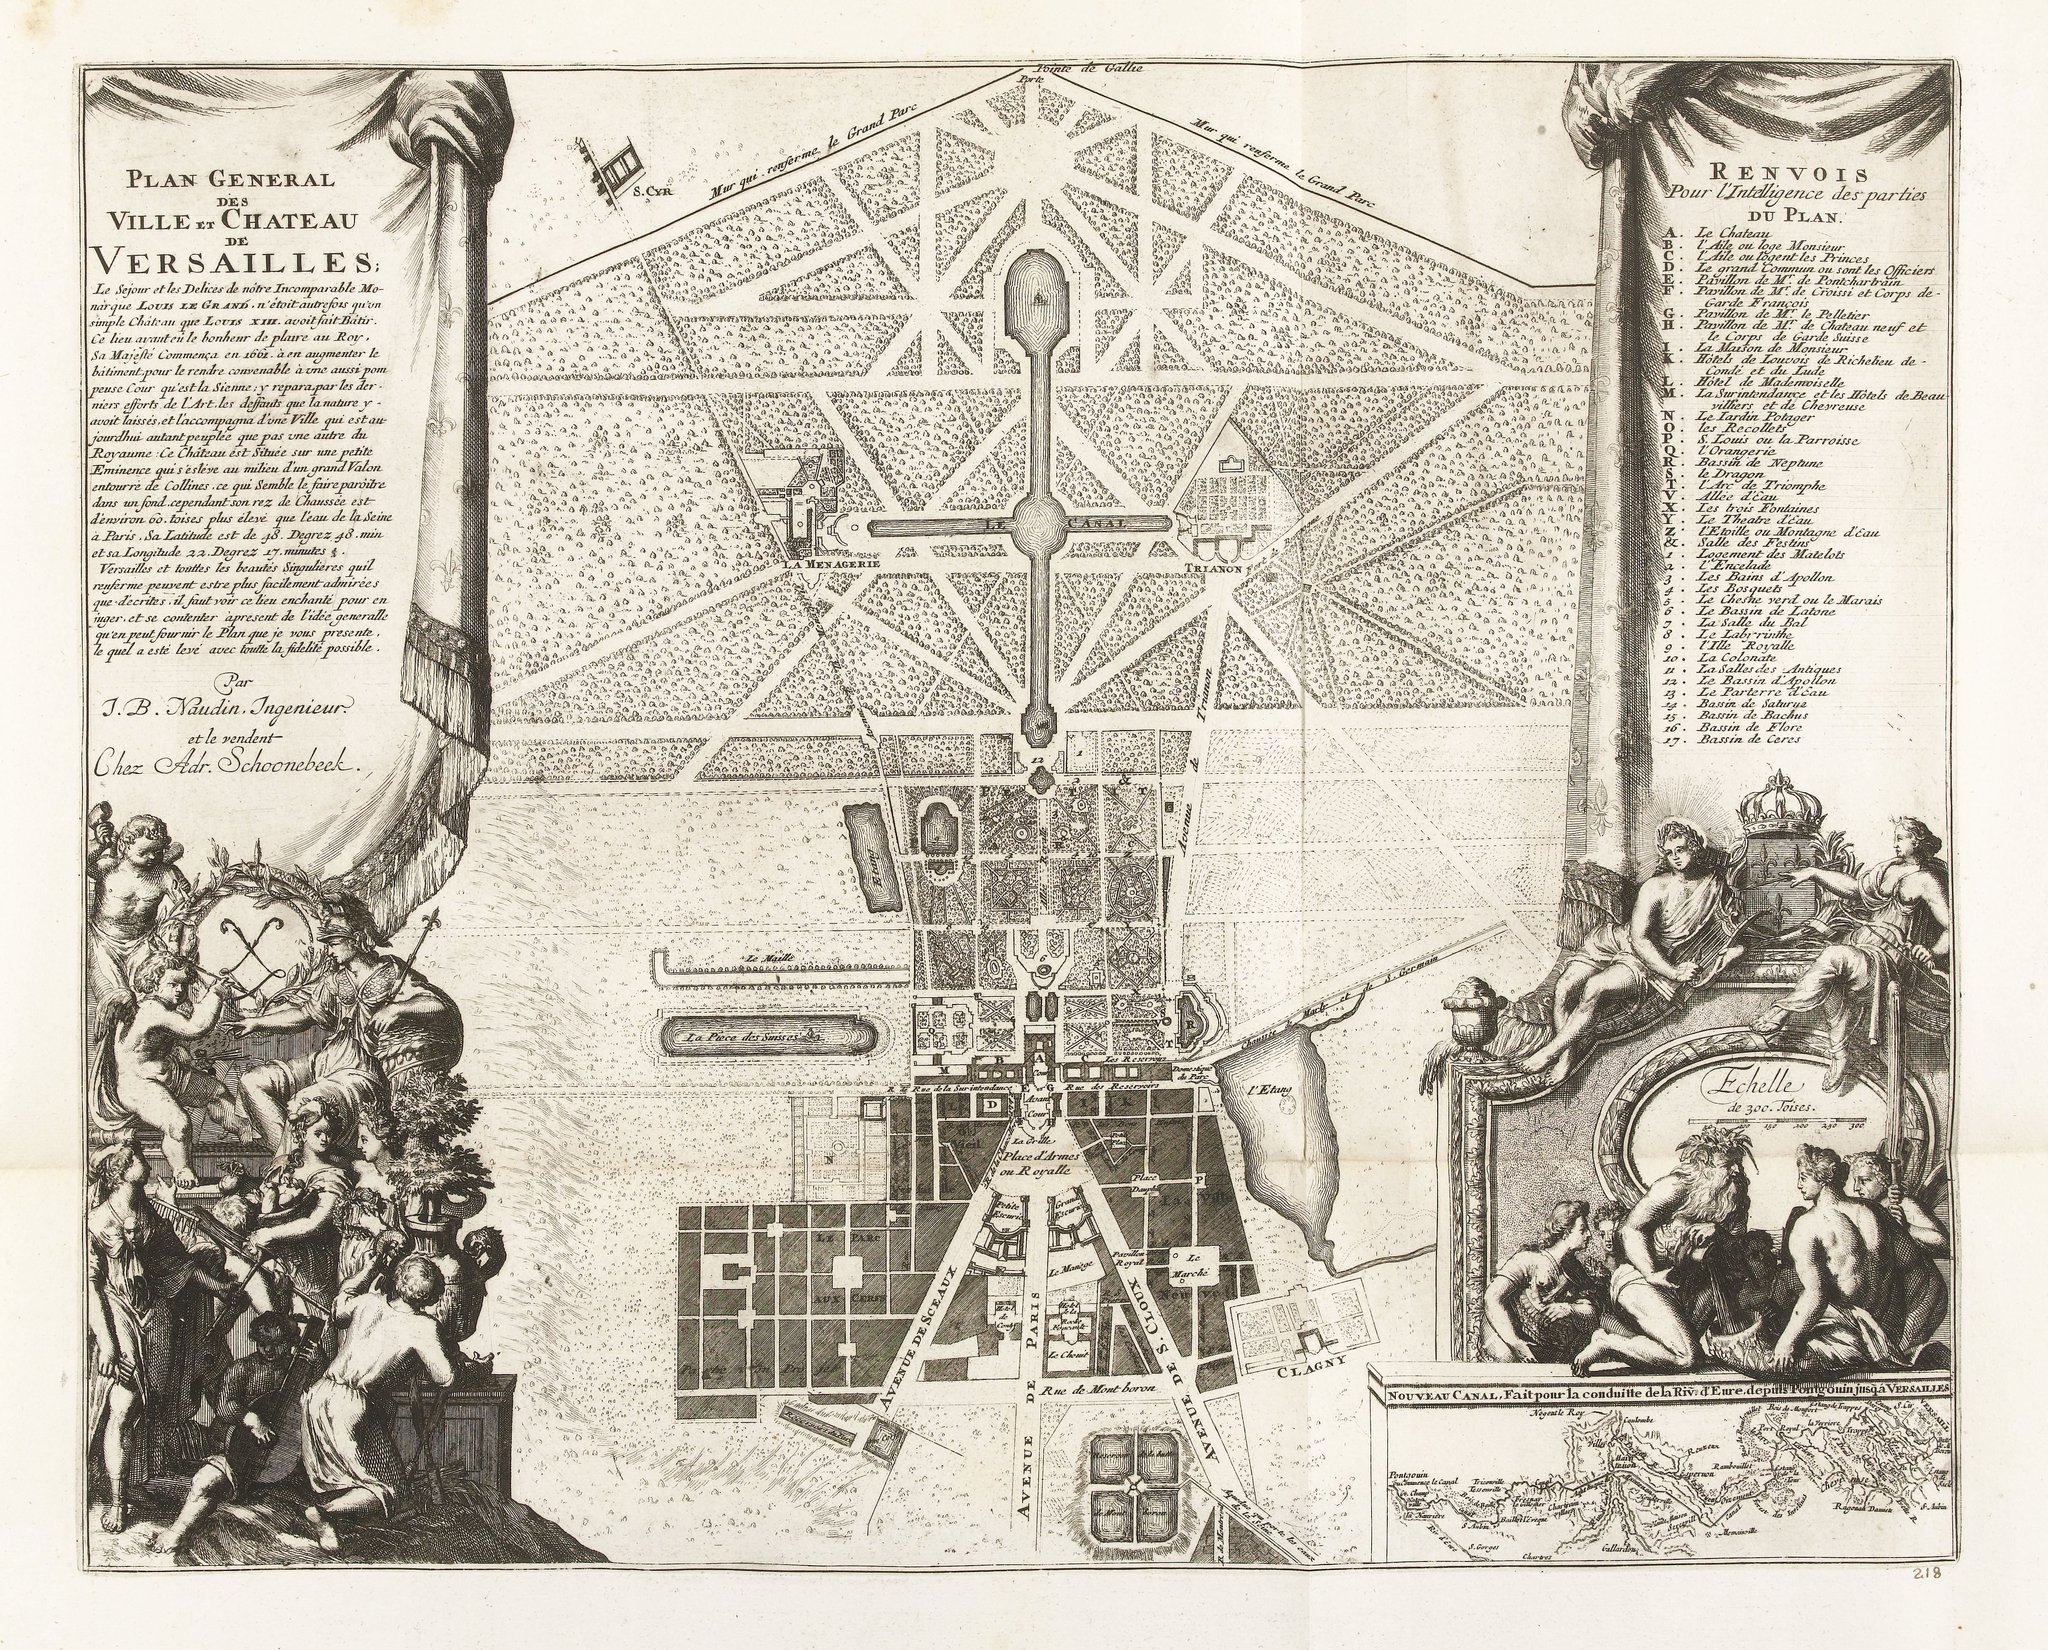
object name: map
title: Plattegrond van kasteel en tuinen van Versailles, ca. 1702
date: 1702-1703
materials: paper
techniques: etching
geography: northern netherlands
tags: palace, french or architectonic garden; formal garden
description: Plattegrond van van het kasteel en de tuinen van Versailles. Met cartouches versierd met allegorische figuren. Plaat nr. 218 in het prentwerk bestaande in totaal uit 276 genummerde platen van vermaarde sterke steden en vestingen in het kader van de Spaanse Successieoorlog. Voor het merendeel zijn deze platen gekopieerd naar de anonieme Franse platen: in Les forces de l'Europe en in: Le theatre de la guerre, dans les Pays-Bas, beide oorspronkelijk uitgegeven door Nicolas de Fer te Parijs (1693-1697) in het kader van de Negenjarige Oorlog. Titel en opschriften in de plaat in het Frans.